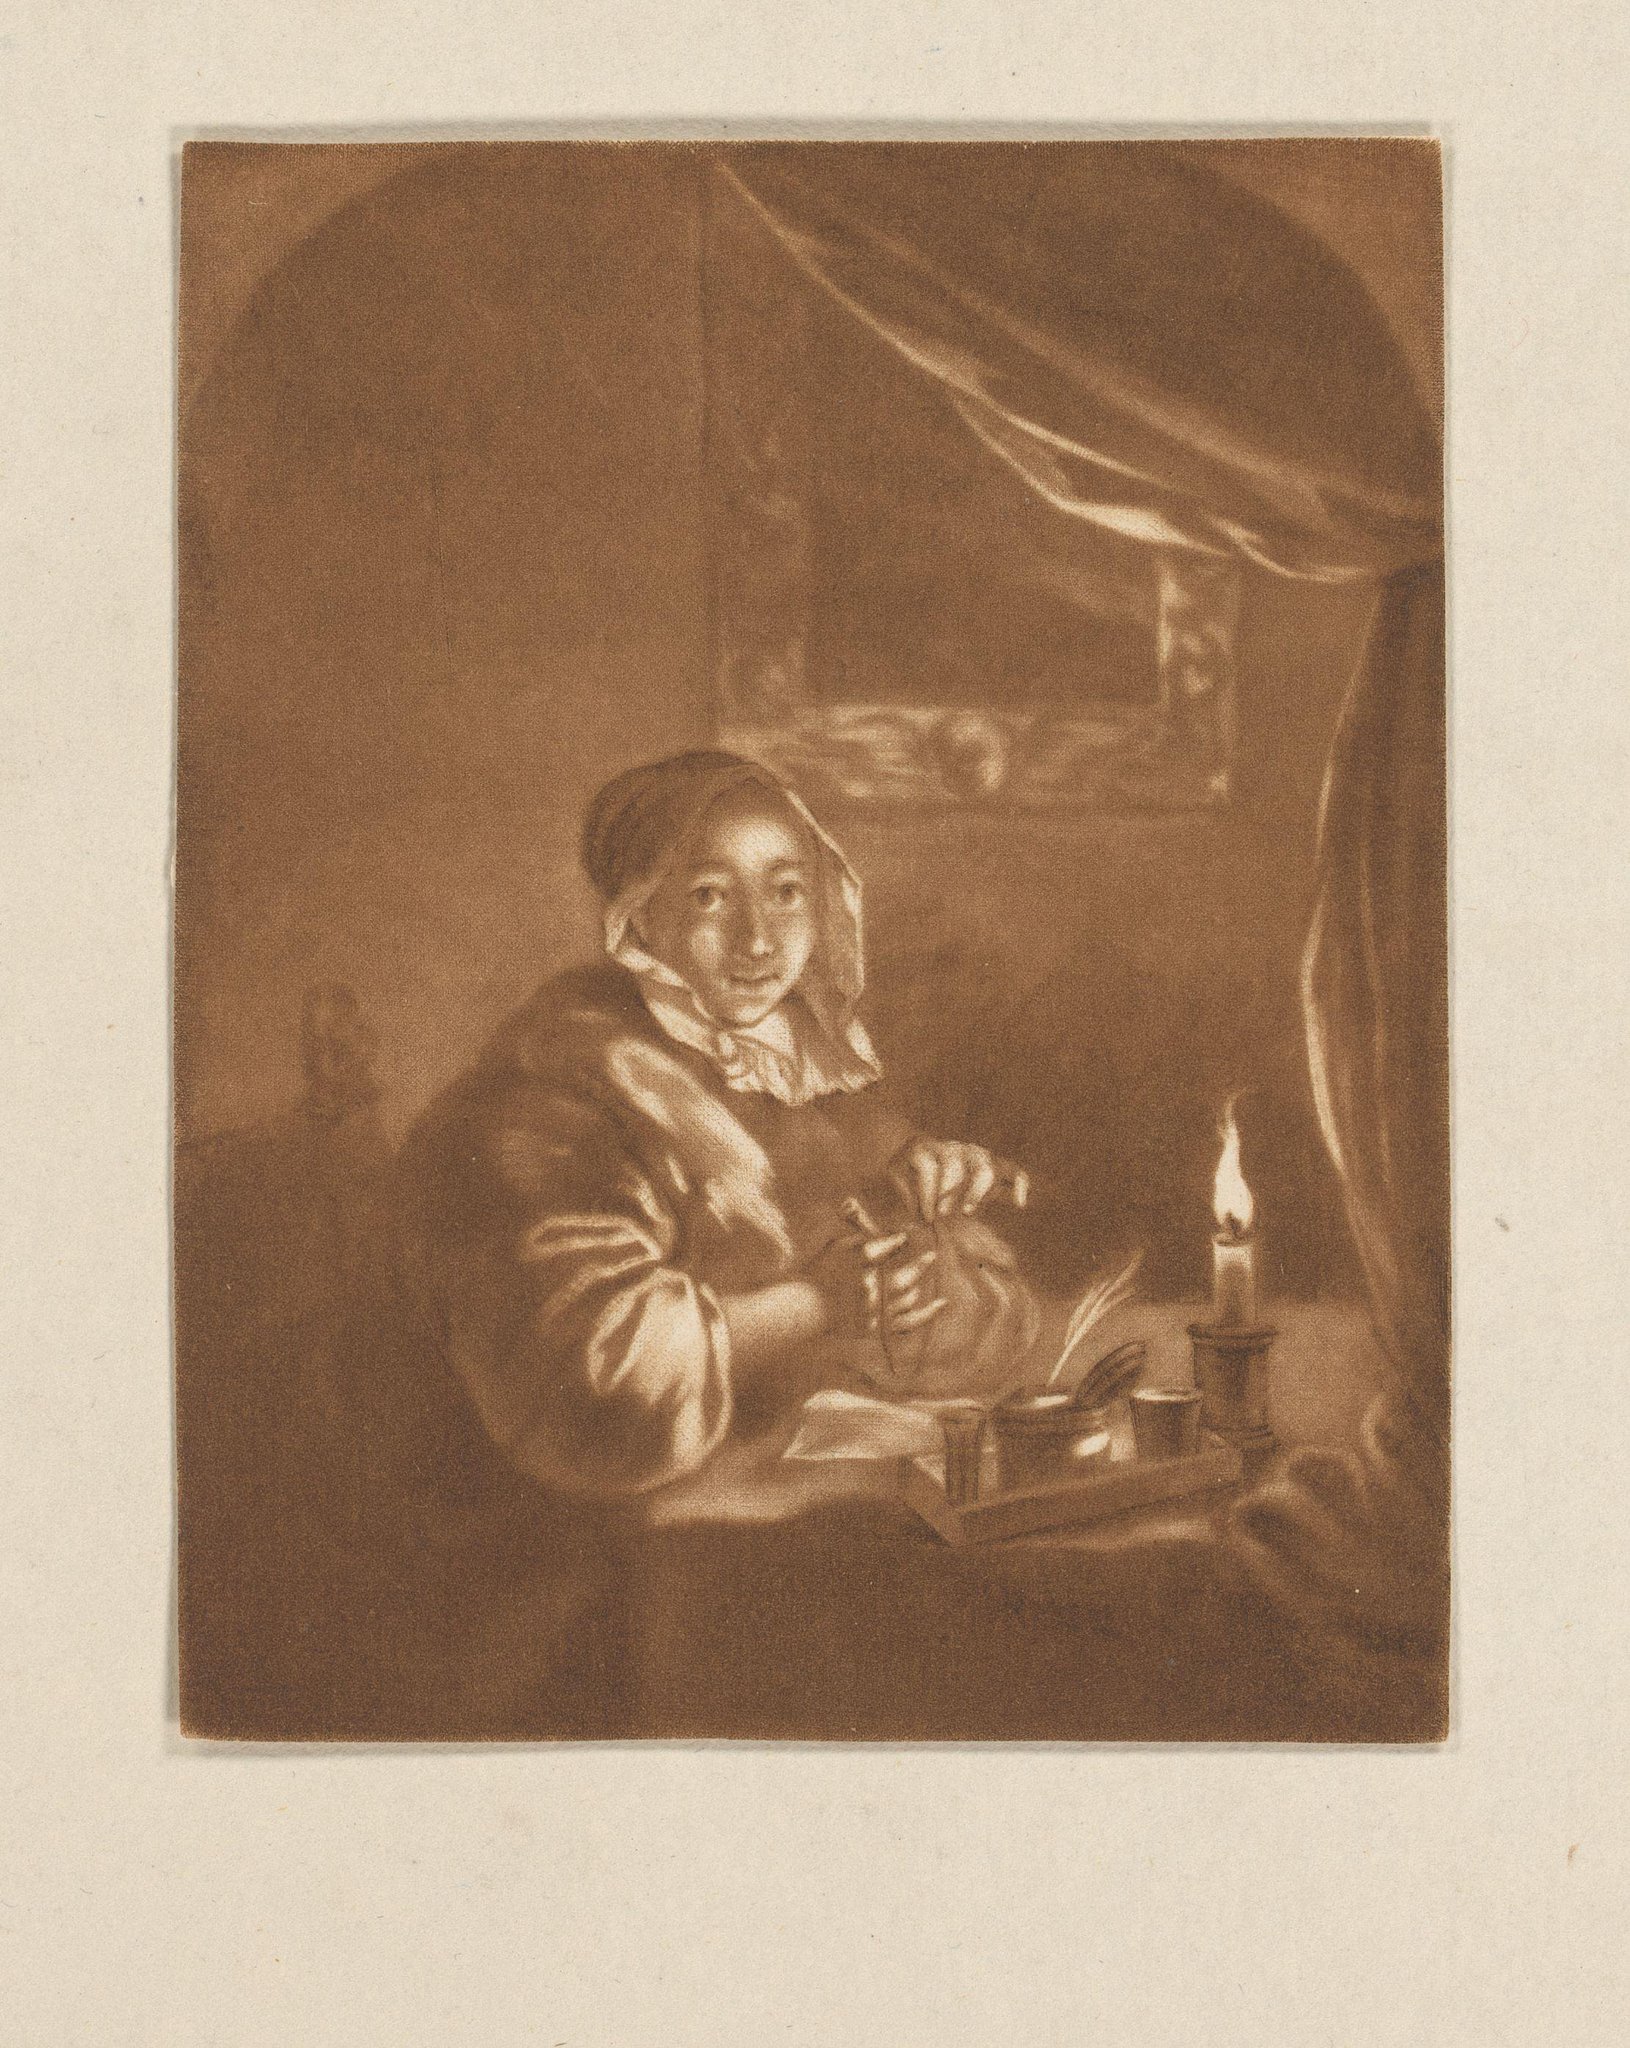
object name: print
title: Dame bij kaarslicht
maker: cornelis ploos van amstel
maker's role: draughtsman, print maker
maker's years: 1726-1798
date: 1736-1798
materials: paper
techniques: etching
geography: amsterdam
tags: candle, (other forms of) needlework, e.g.: crocheting, knitting, embroidering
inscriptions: collector's mark: Lugt 2725, collector's mark: ‘RIJKS / MUSM’, inscription: ‘Geoffreerd aan mynen Kunstlievende Oom de Heer H Charlon CPvA JC// G. Netscher del/ CPloos v Amstel JC Fecit’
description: Een vrouw, zittend aan tafel met een breiwerk in de handen, bij kaarslicht. De prent ligt los in een album, zie blad 57.